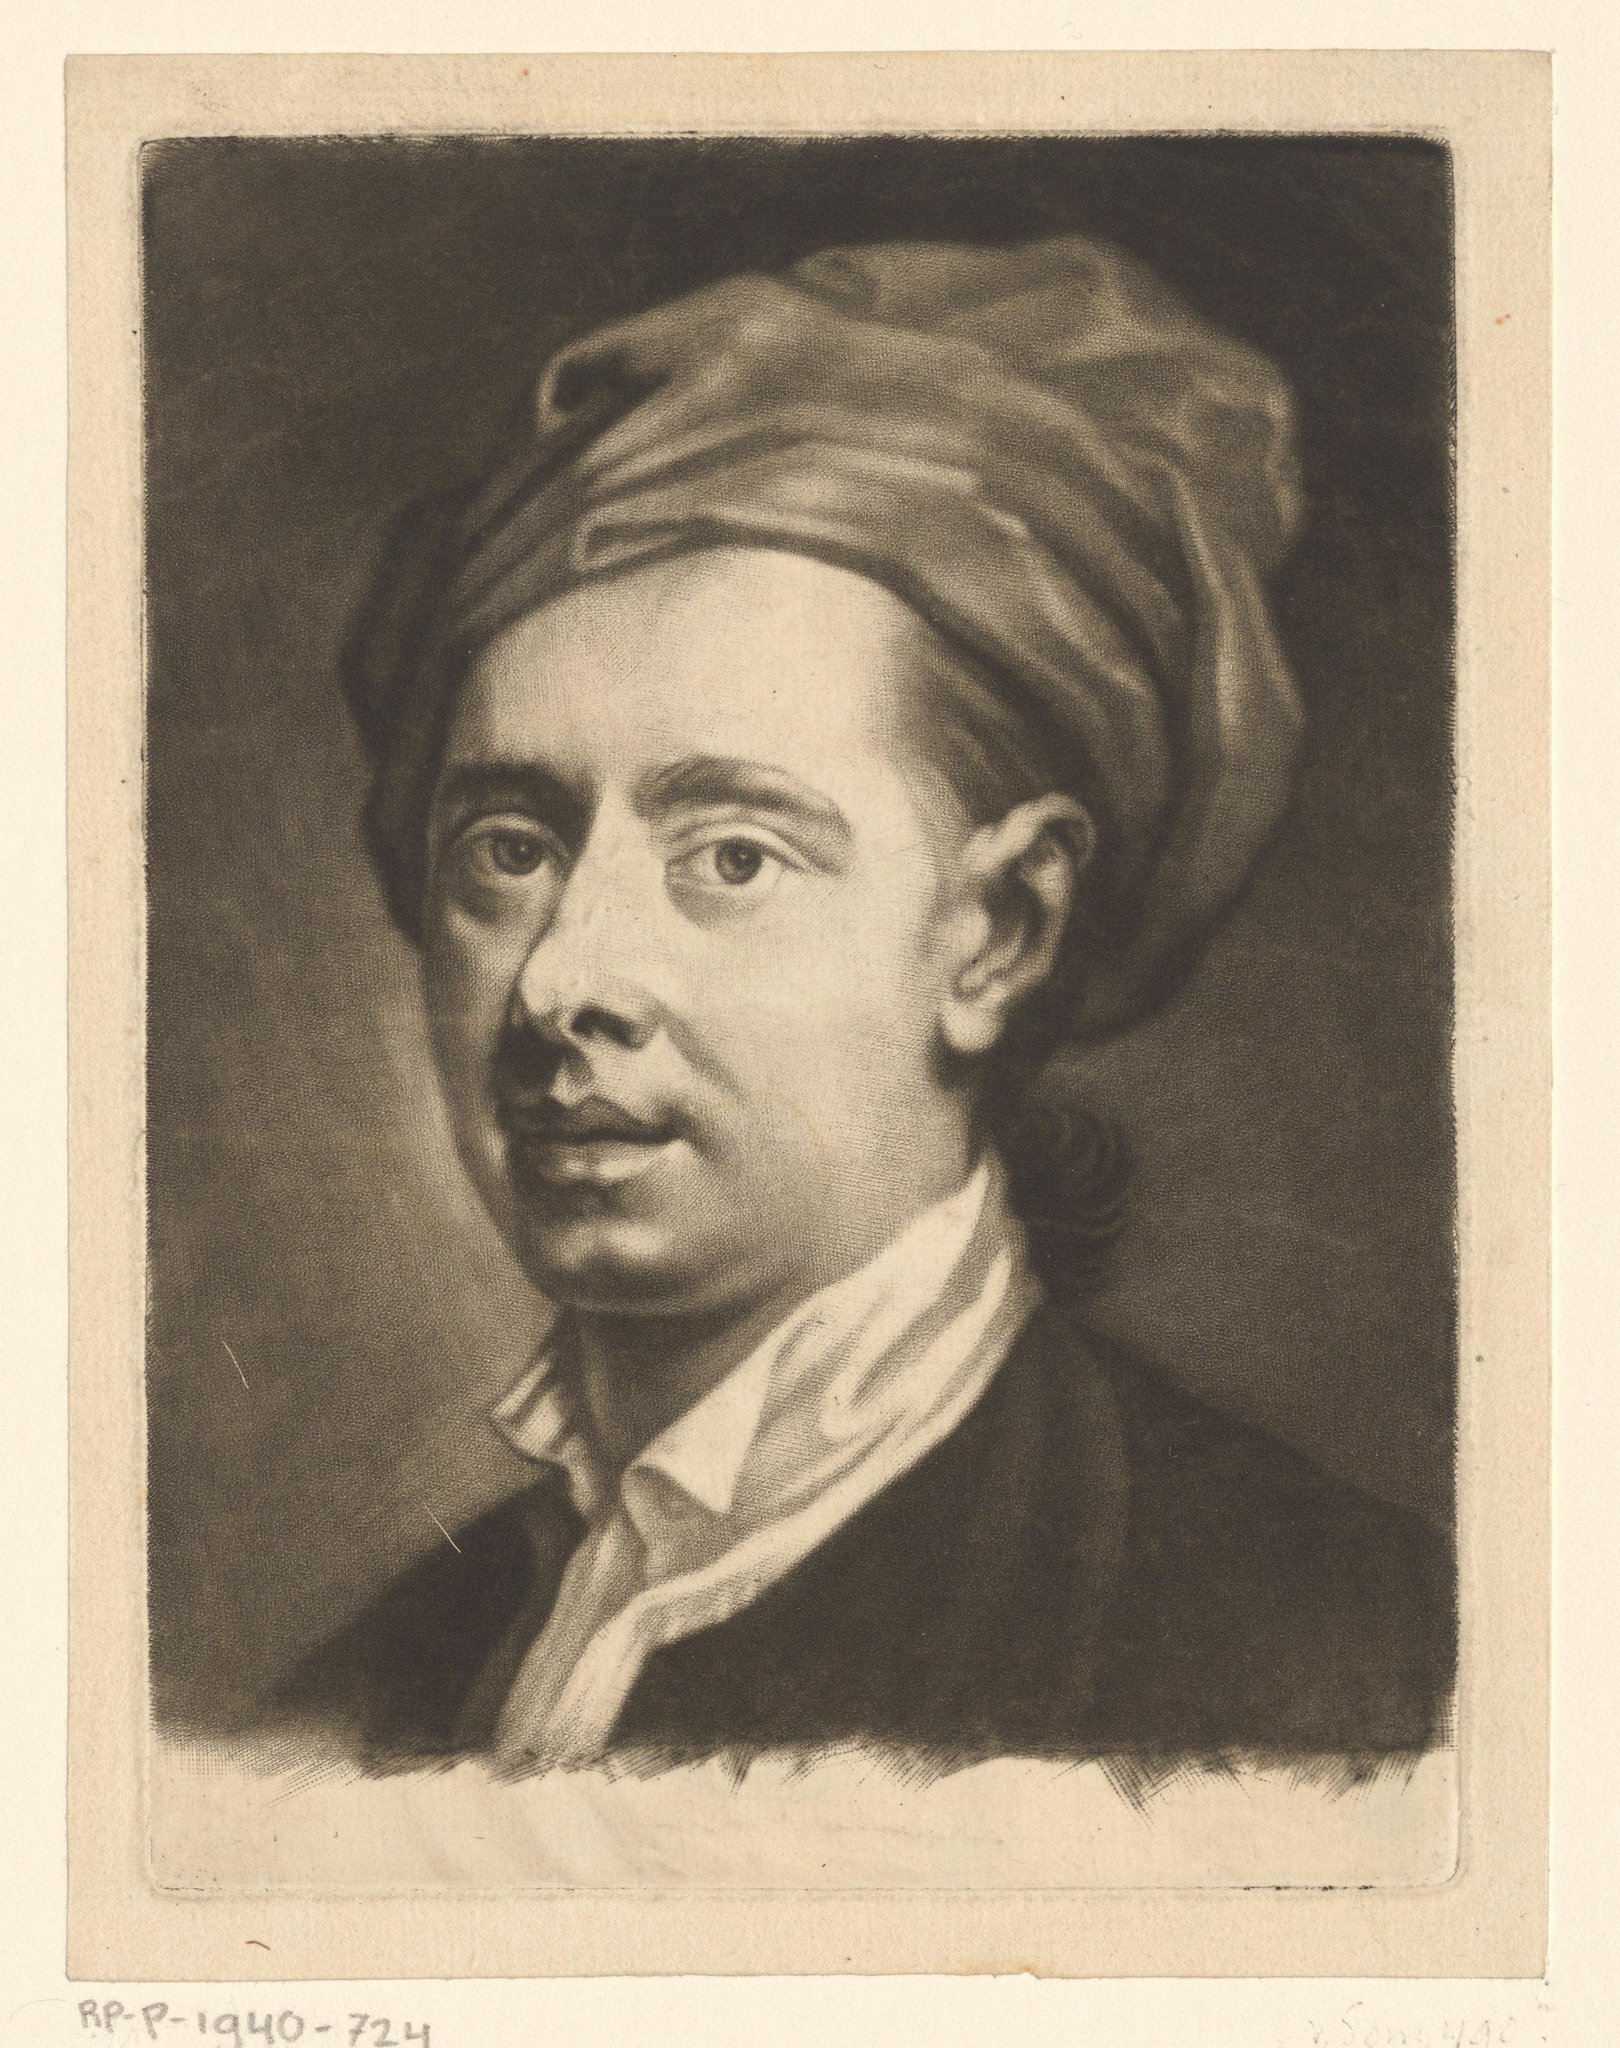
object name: print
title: Portret van Richard van Bleeck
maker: pieter van bleeck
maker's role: print maker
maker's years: 1700-1764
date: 1710-1764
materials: paper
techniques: mezzotint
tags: the hague, london, draughtsman, richard van bleeck, historical persons, portrait, self-portrait of painter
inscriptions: collector's mark: Lugt 2228, inscription: ‘Cat Winckler IIIa [...]’, collector's mark: Lugt 2760